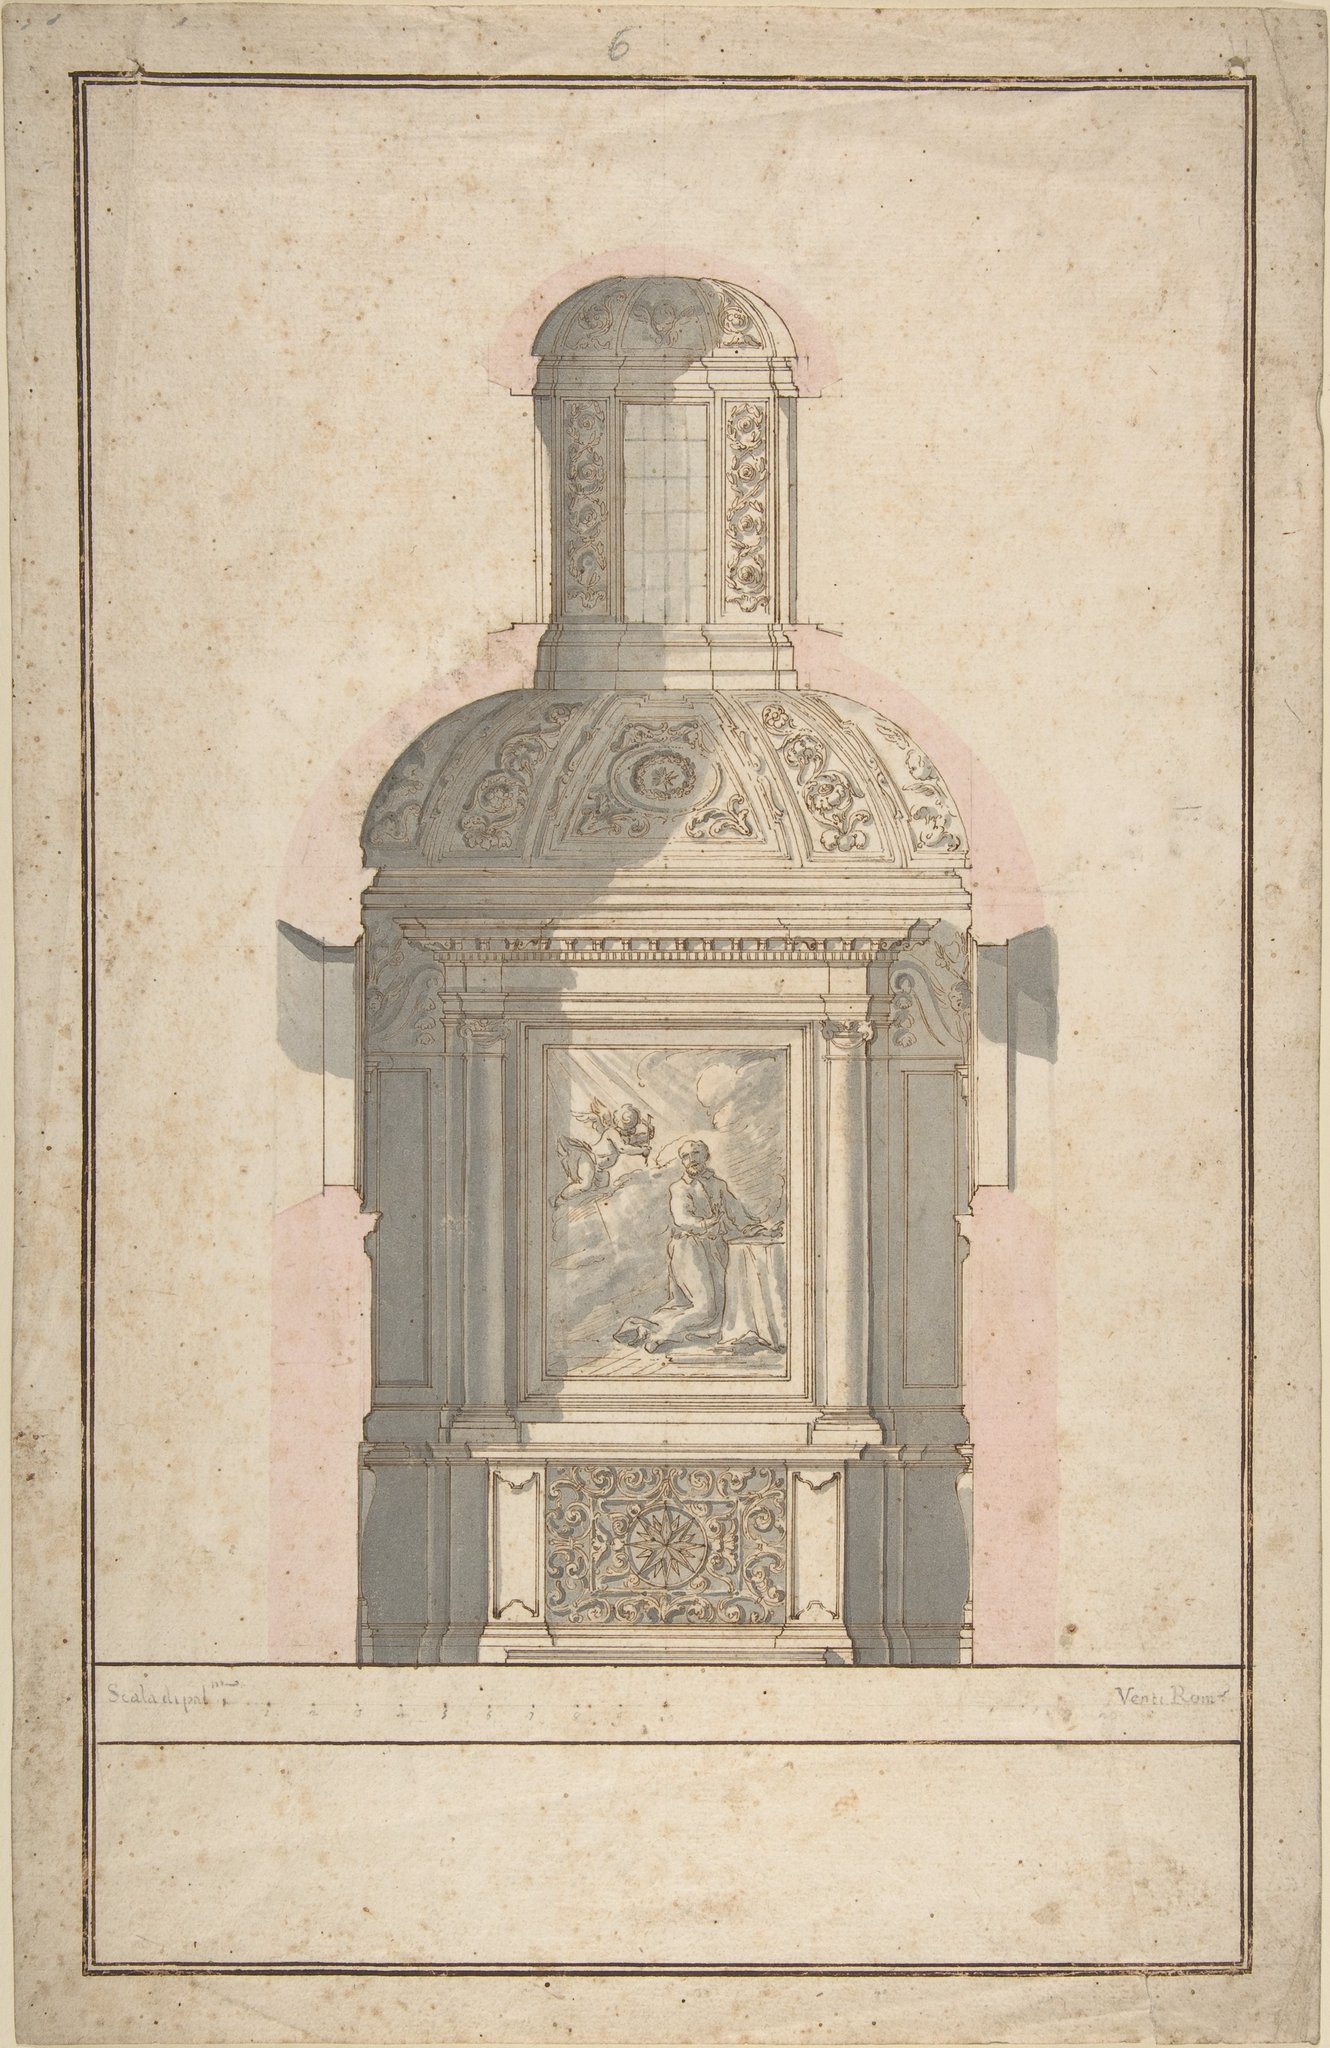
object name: drawing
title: Architectural Drawing for a Chapel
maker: anonymous, italian, roman, 18th century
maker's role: artist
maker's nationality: italian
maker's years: 1700-1800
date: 1701-1800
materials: ink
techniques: pen, wash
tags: men